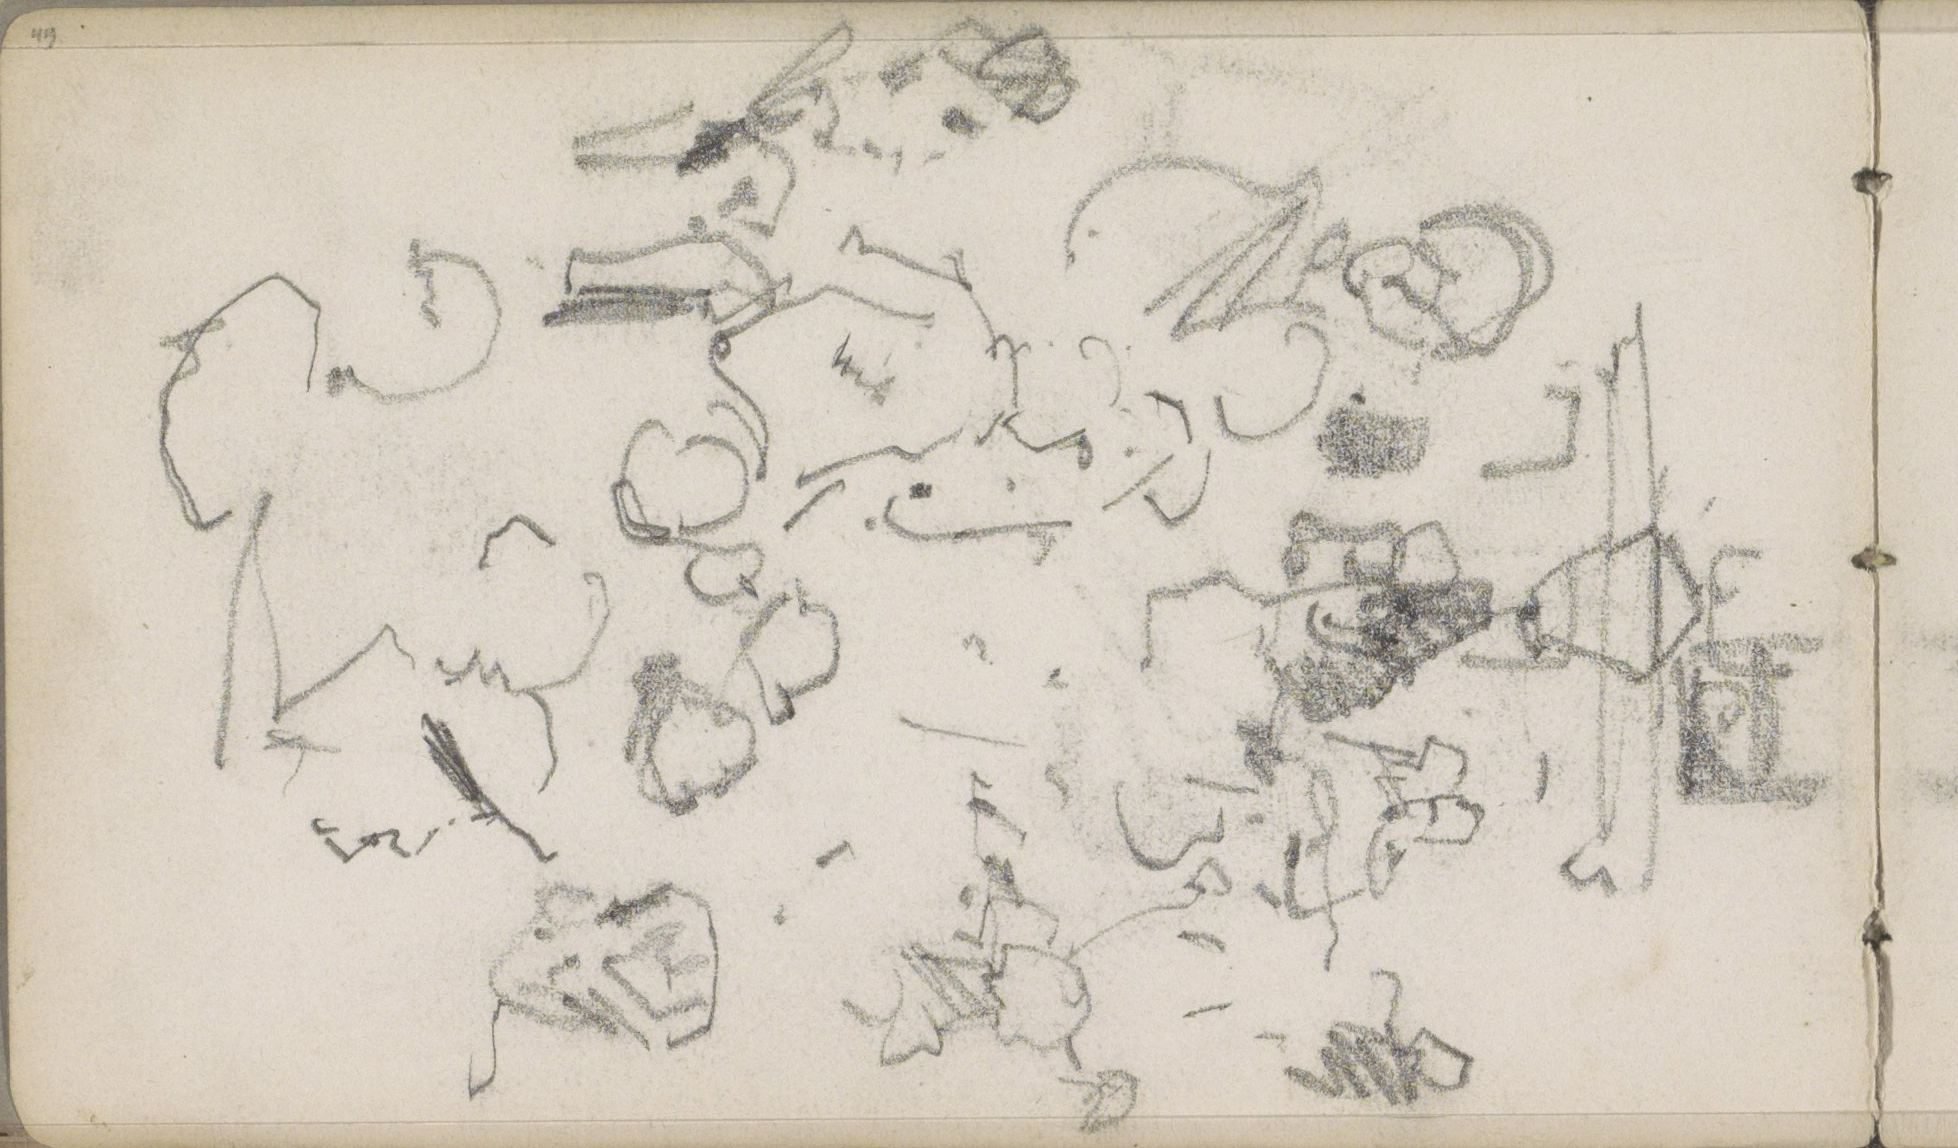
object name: sketchbook leaf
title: Figuurstudies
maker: george hendrik breitner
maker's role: draughtsman, painter, print maker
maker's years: 1857-1923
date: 1881-1883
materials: paper, pencil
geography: north brabant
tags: adult woman, adult man, street lighting, civic architecture; edifices; dwellings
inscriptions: kleurnotitie, handgeschreven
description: Op de achtergrond een gebouw en een straatlantaarn. Pagina 49 uit een schetsboek met 42 bladen.